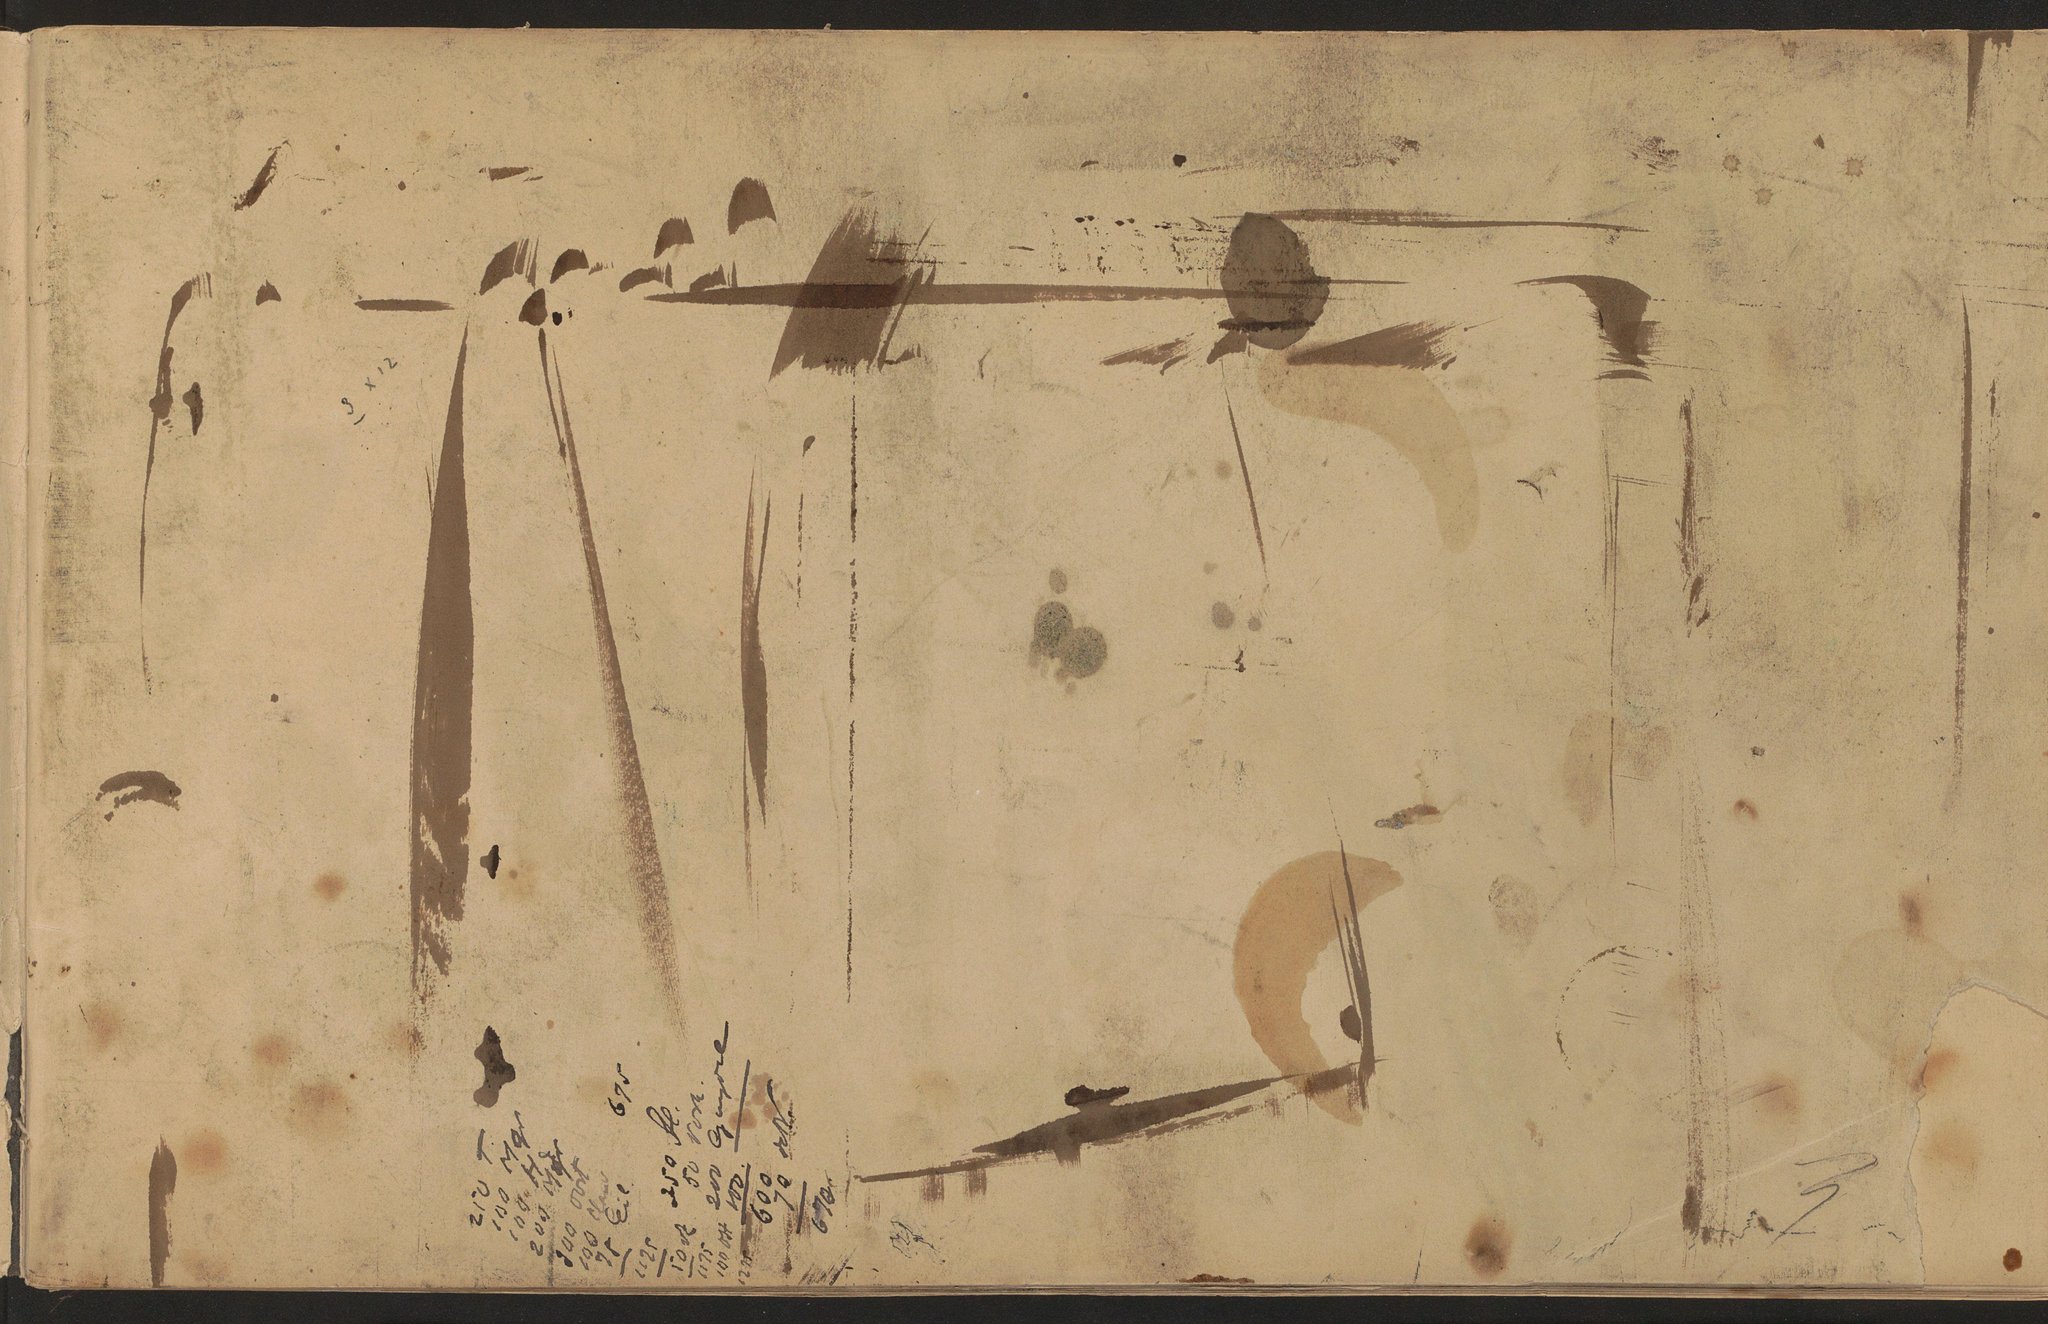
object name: sketchbook leaf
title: Annotaties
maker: willem witsen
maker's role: draughtsman, painter, print maker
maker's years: 1860-1923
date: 1897-1910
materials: paper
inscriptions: annotation: ‘[...]’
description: Pagina 1 uit een schetsboek met 19 bladen.